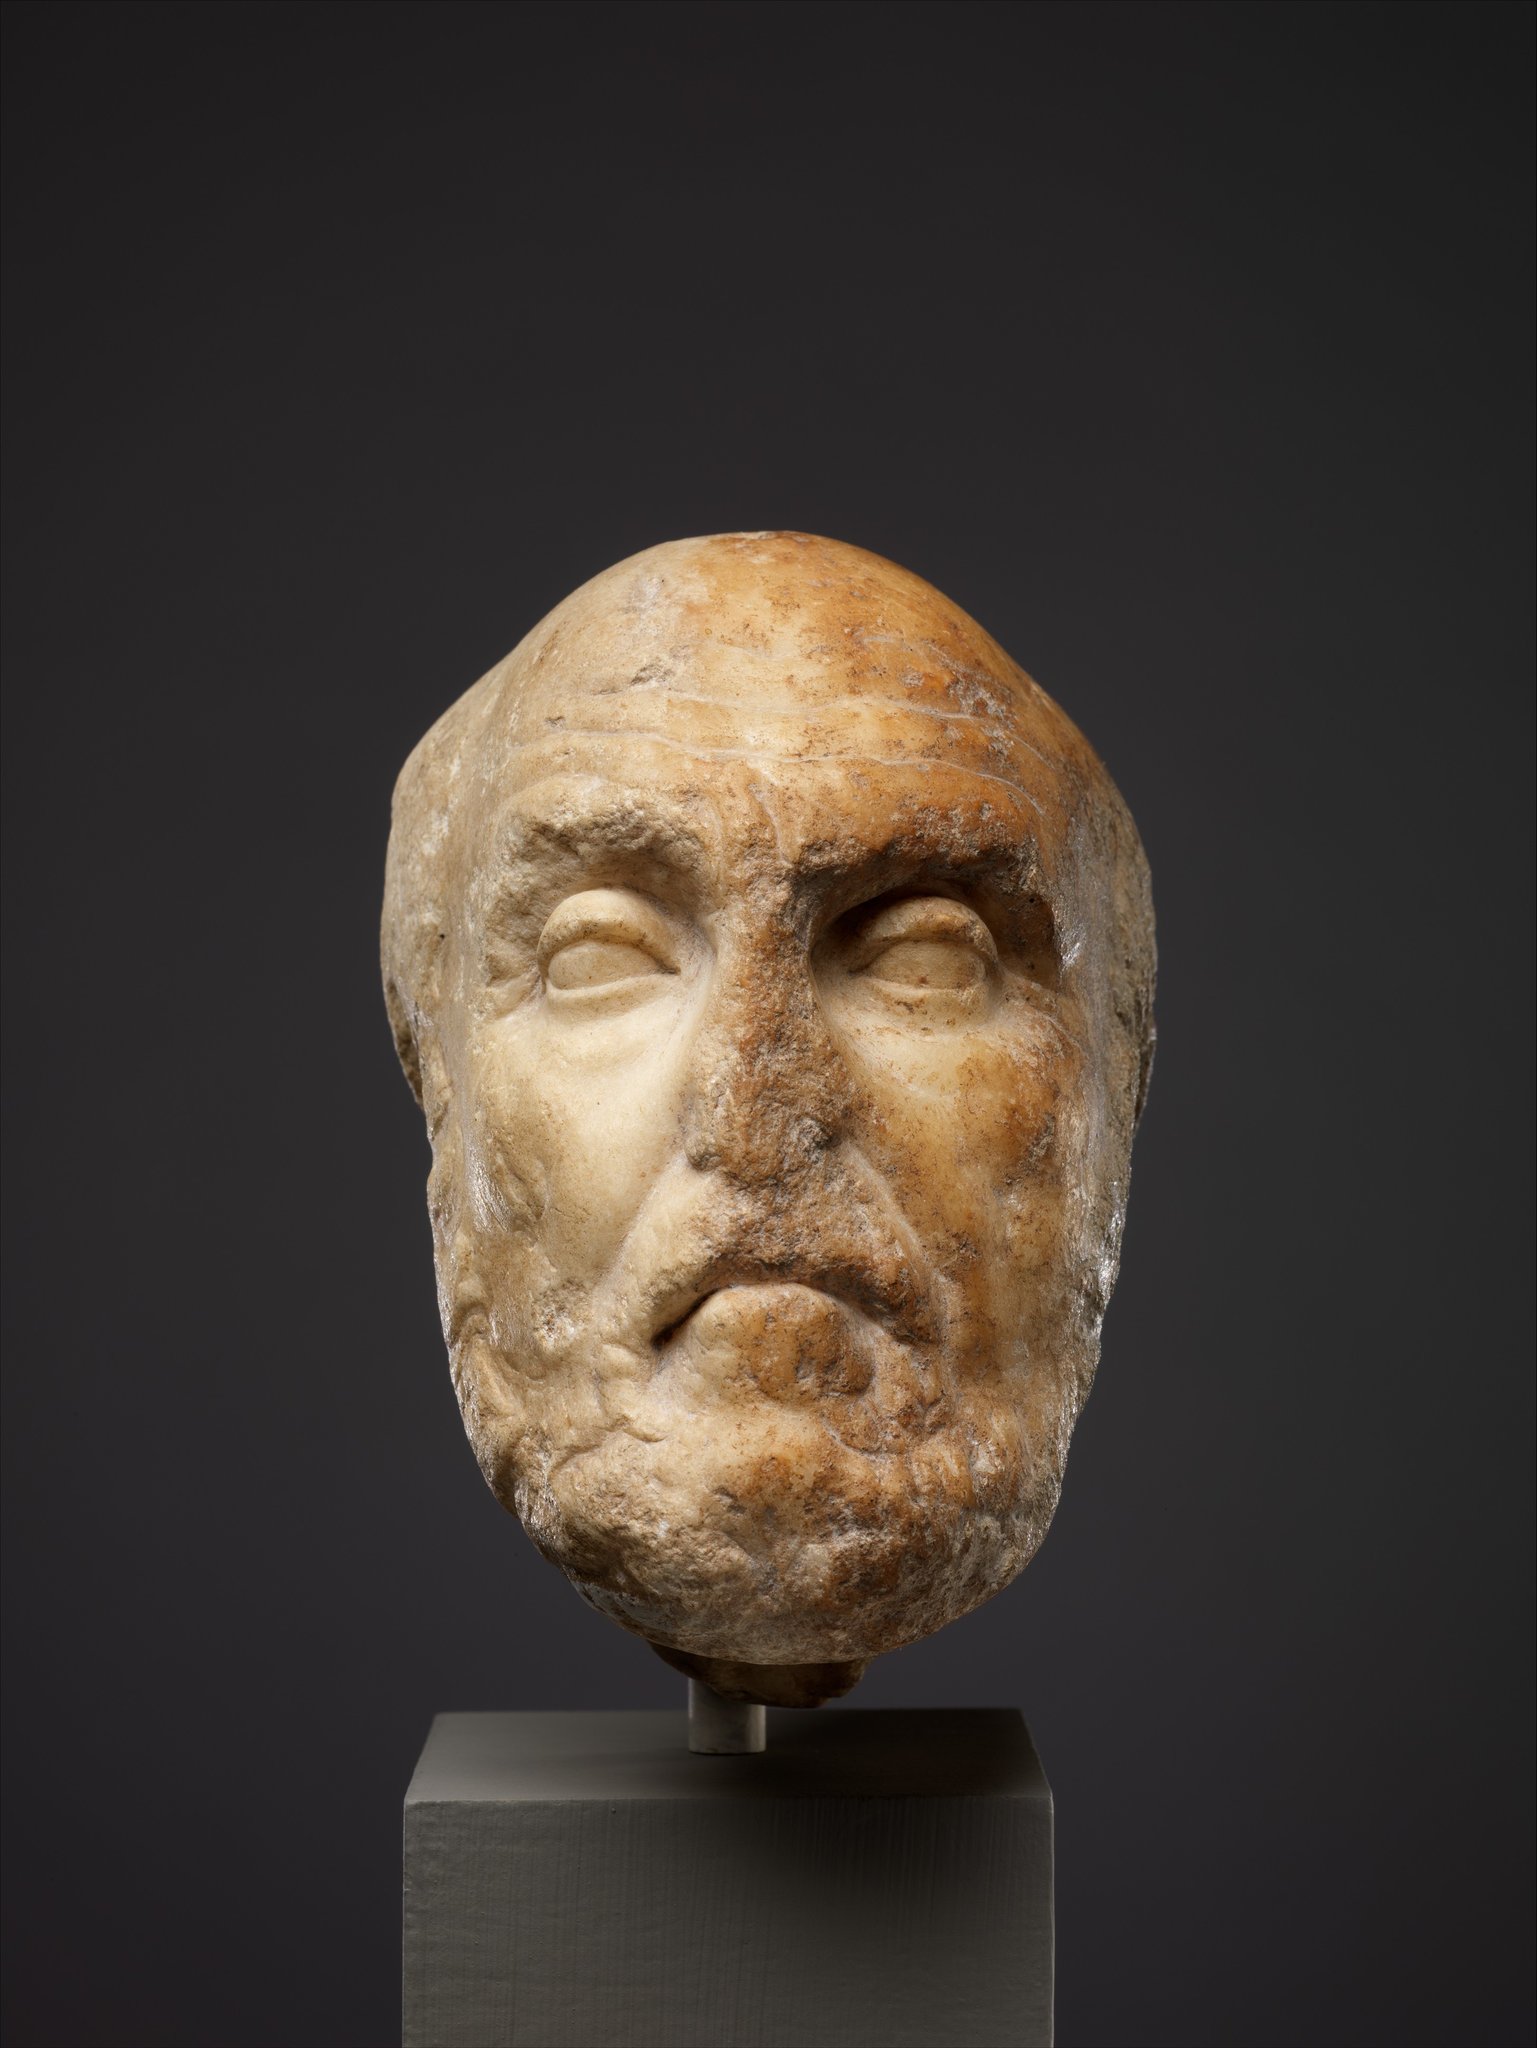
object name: head of chrysippos, the philosopher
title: Marble portrait head of the philosopher Chrysippos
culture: roman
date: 1-100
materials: marble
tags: heads,men